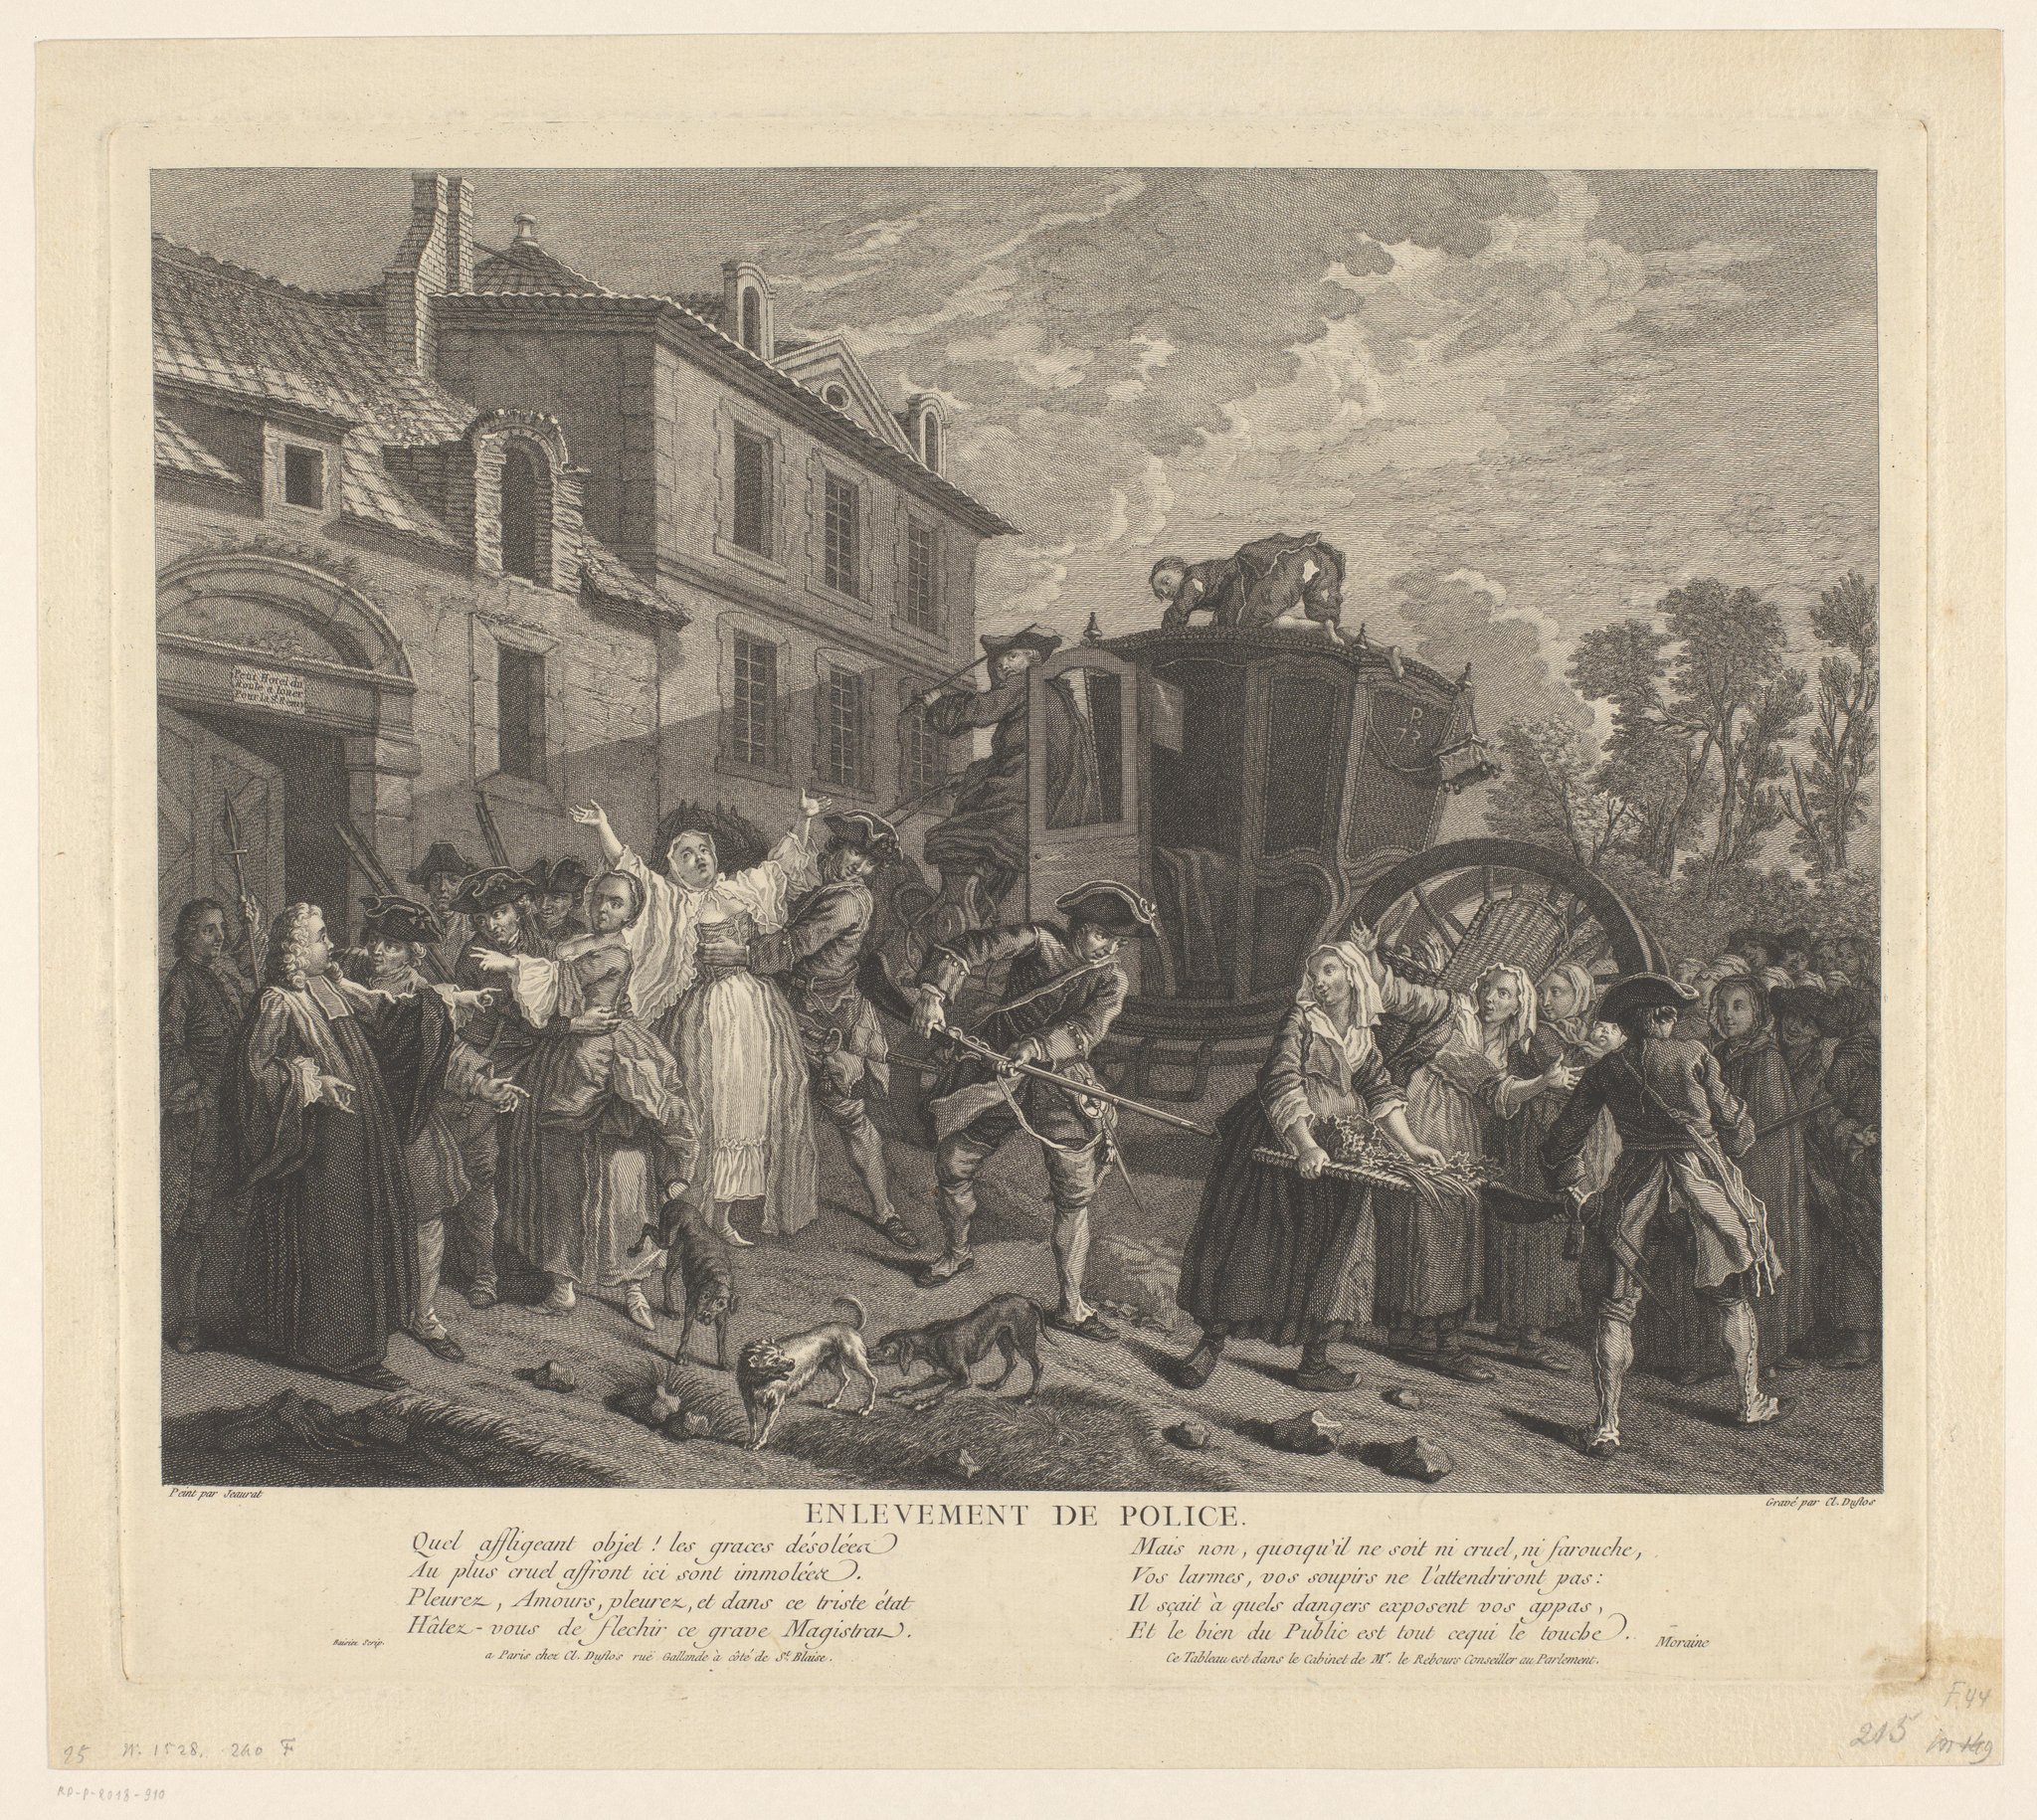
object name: print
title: Ontruiming van een hotel door de politie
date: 1765-1768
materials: paper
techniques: engraving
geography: france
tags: four-wheeled, animal-drawn vehicle, e.g.: cab, carriage, coach, hotel, hostelry, inn, police